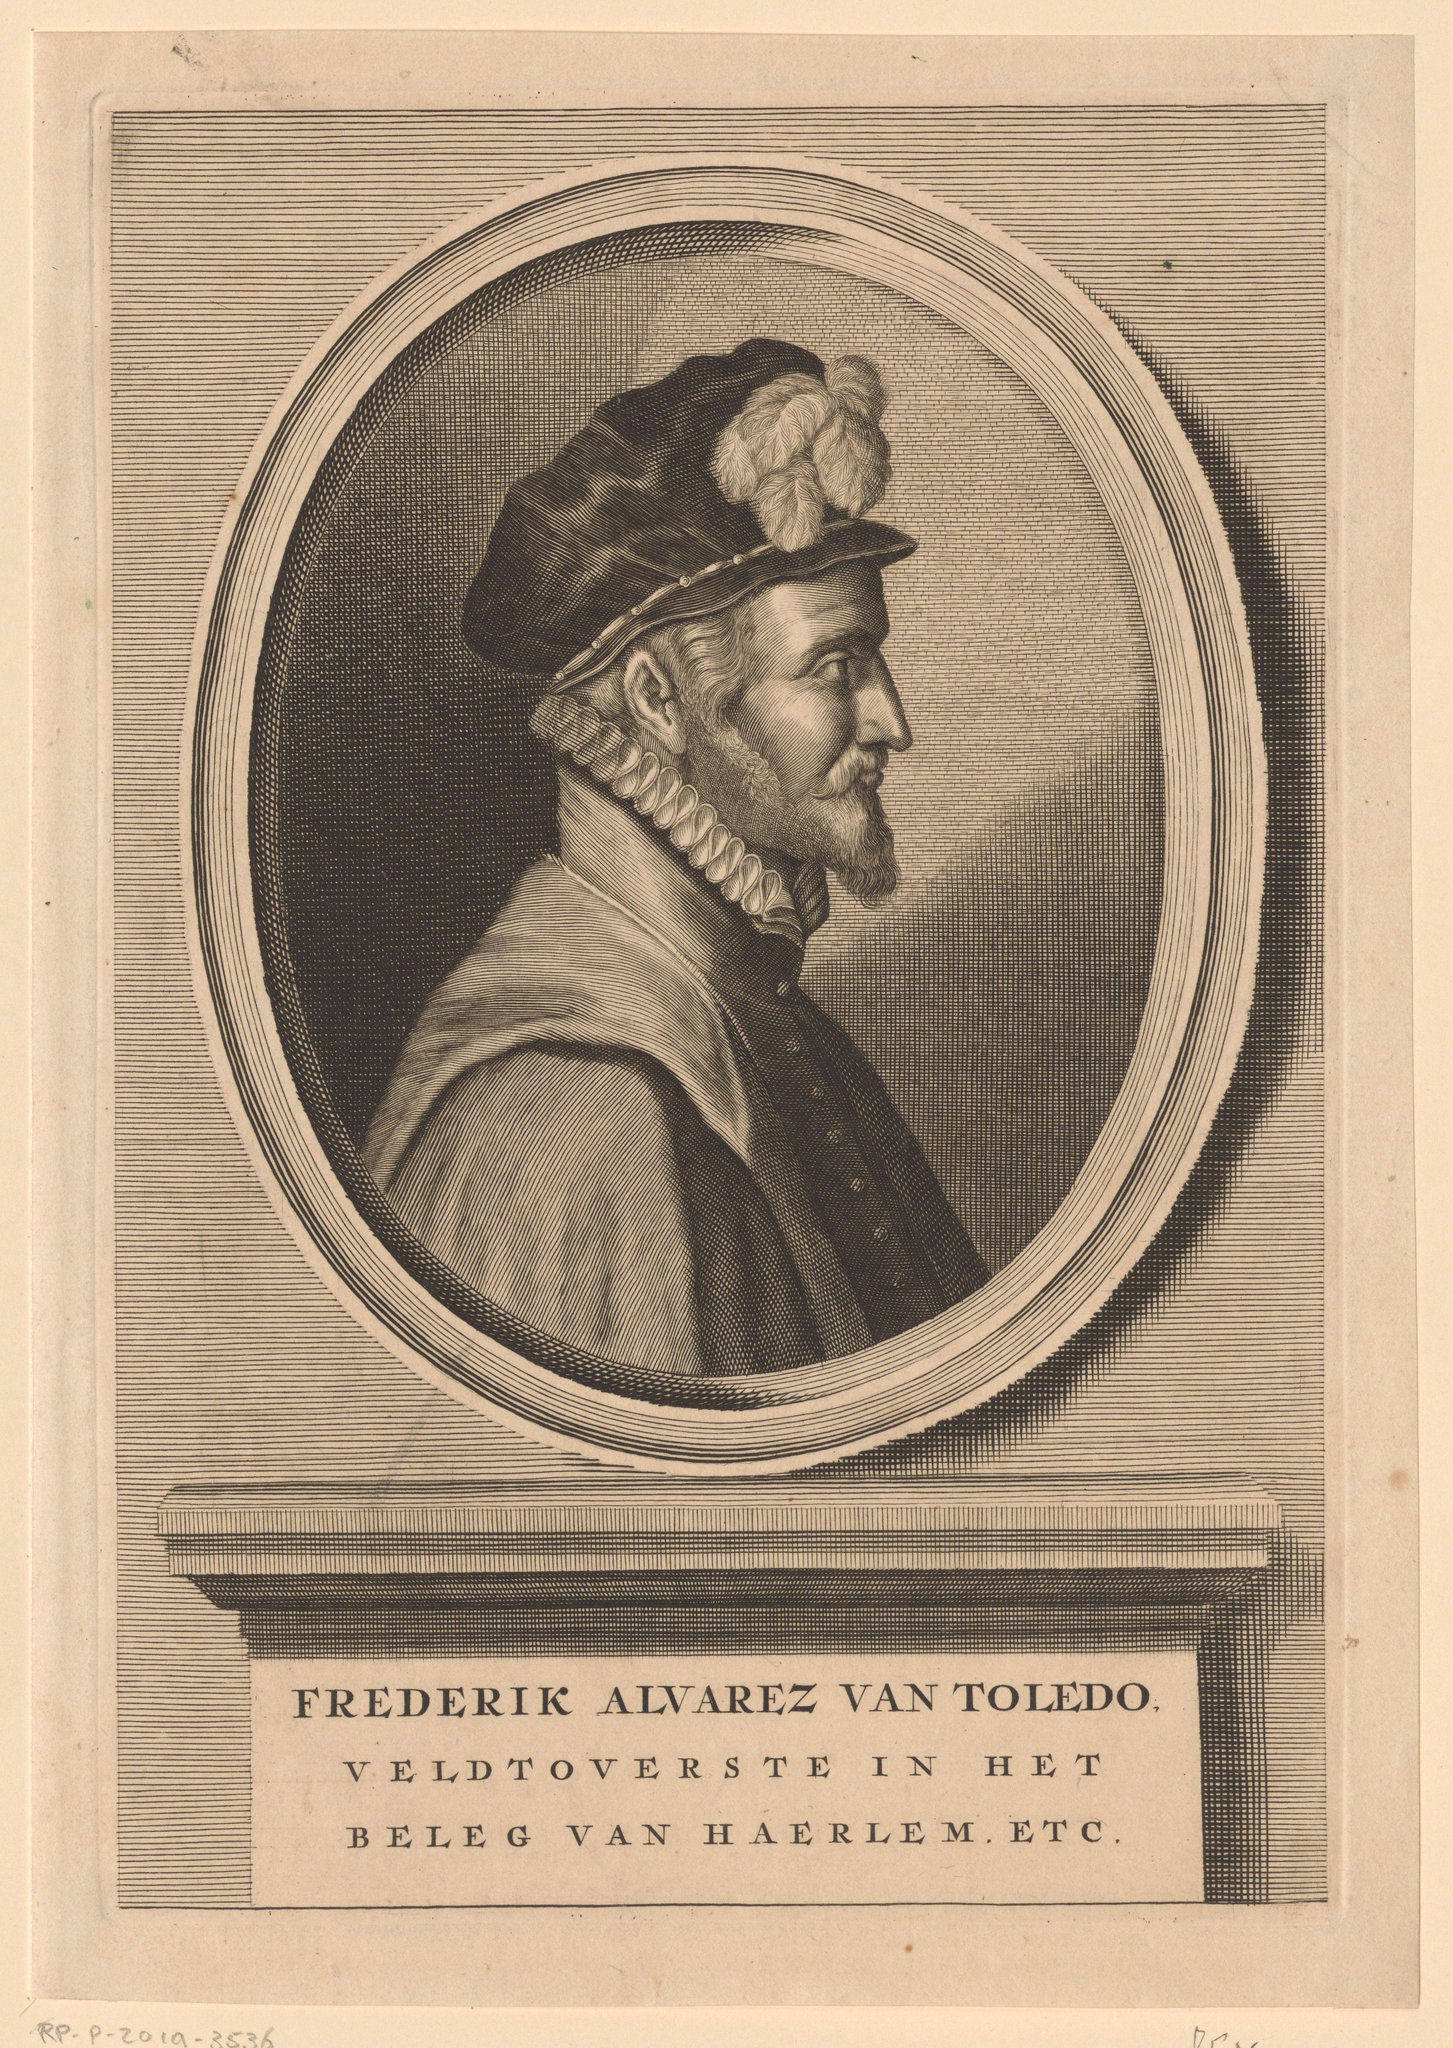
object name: book illustration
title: Portret van Fadrique Álvarez de Toledo, hertog van Alva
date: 1679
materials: paper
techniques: engraving, etching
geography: amsterdam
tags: historical persons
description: Prent uit: Bor, Pieter Christiaansz. Oorspronck, begin, en vervolgh der Nederlandsche oorlogen, (...). Amsterdam: Joannes van Someren, Abraham Wolgang en Hendrick en Dirk Boom, 1679, dl. 1.